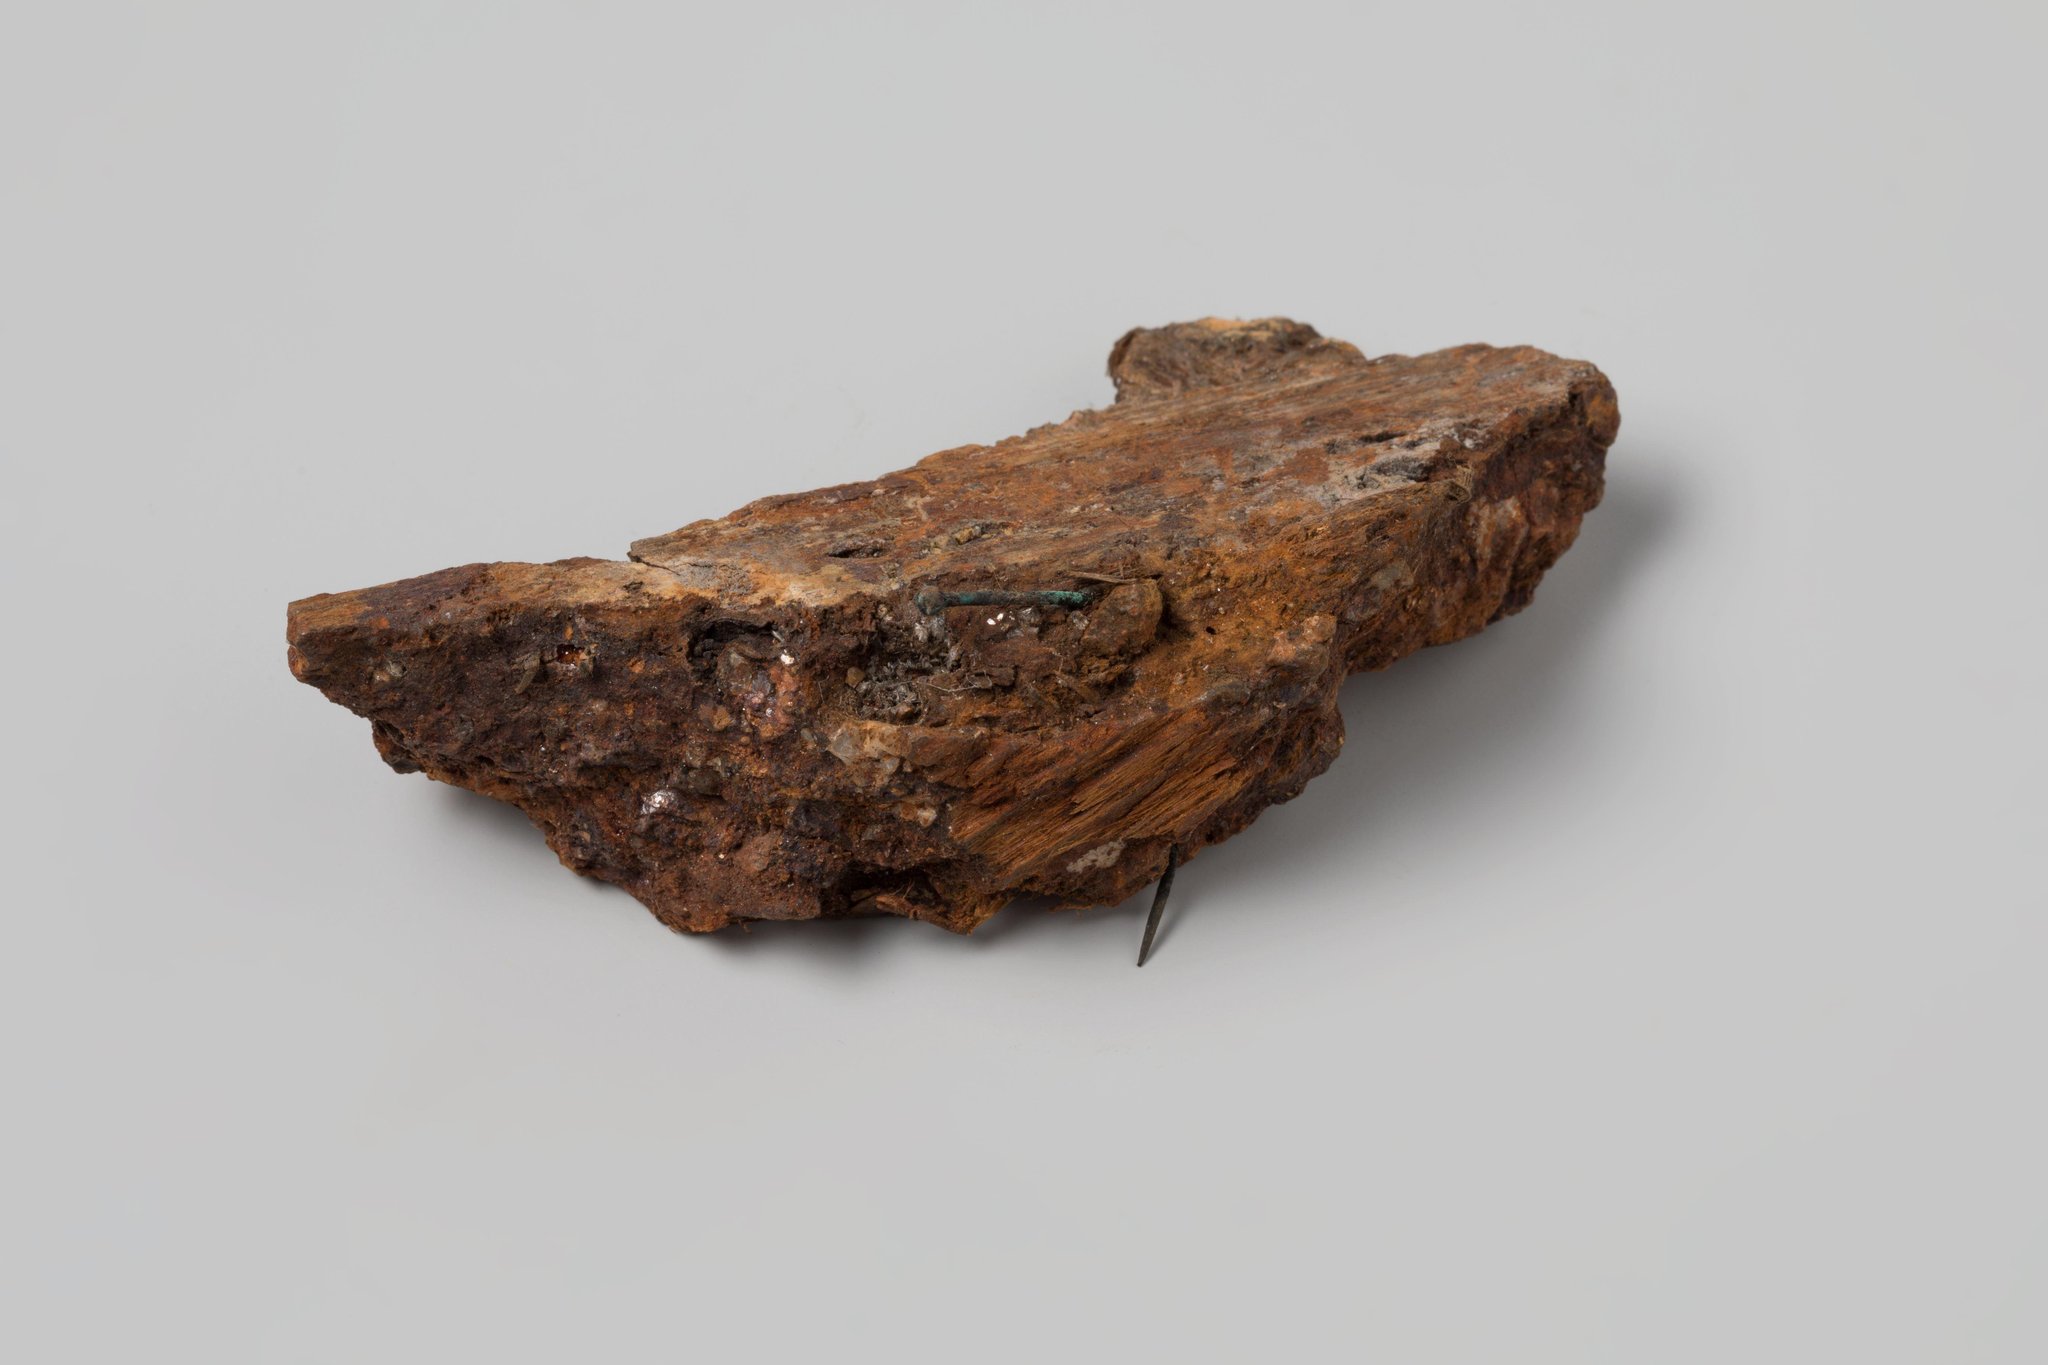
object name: pin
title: Speld in roestig houtfragment uit het wrak van de Oost-Indiëvaarder Hollandia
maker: Anonymous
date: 1700-1743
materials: copper, wood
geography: netherlands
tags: verenigde oostindische compagnie, hollandia (schip), annet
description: Pin, tools and instruments, sewing and sailmaking, pin; concreted, id. NG 1979-434H.